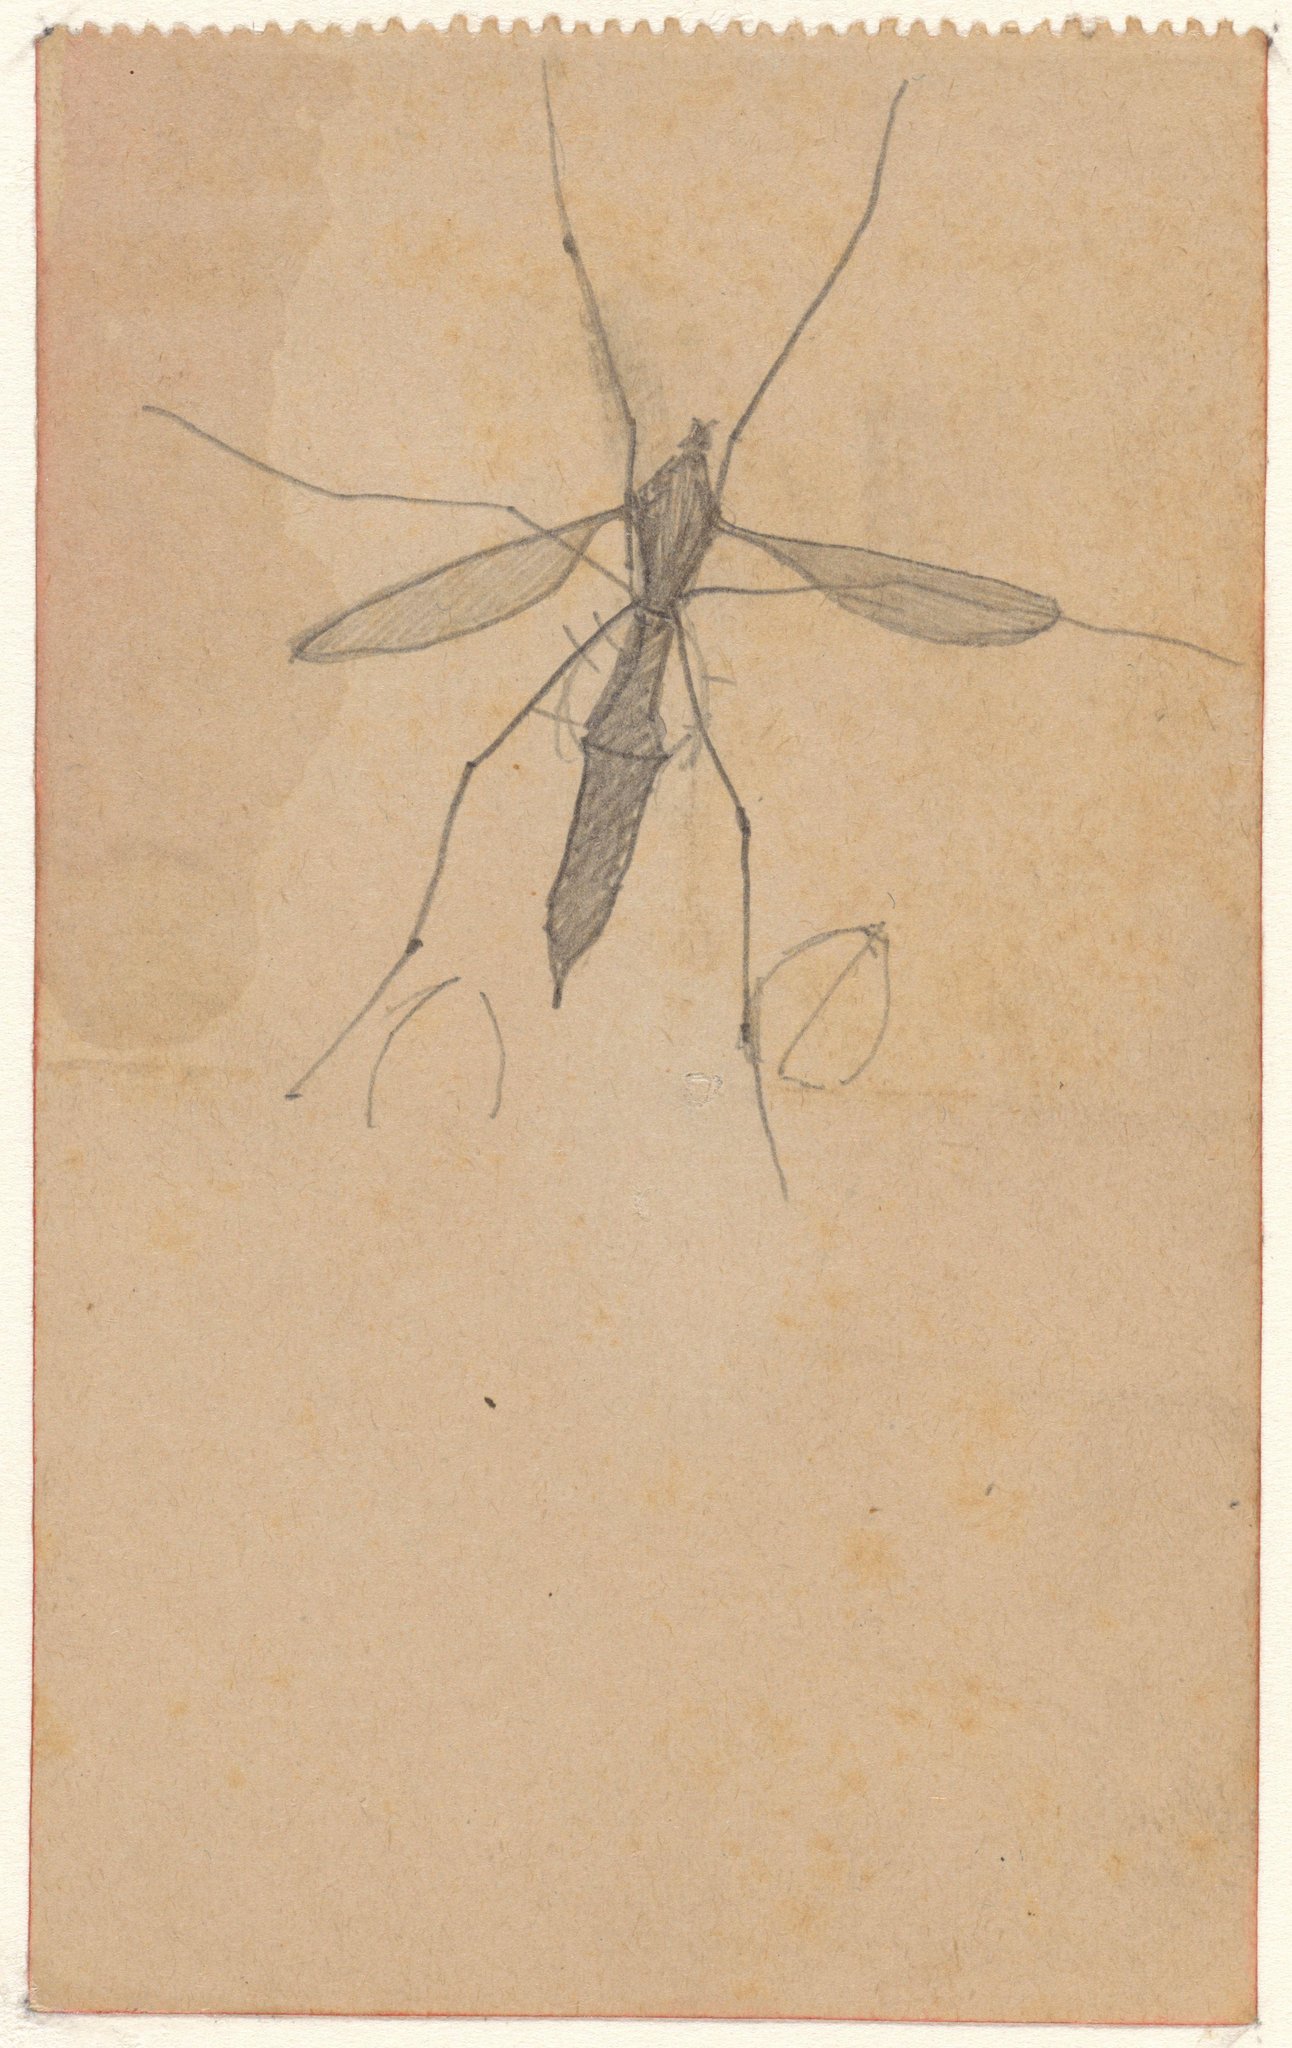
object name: drawing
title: Langpootmug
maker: theo nieuwenhuis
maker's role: designer, draughtsman, print maker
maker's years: 1866-1951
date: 1876-1951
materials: paper, pencil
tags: insects: crane fly